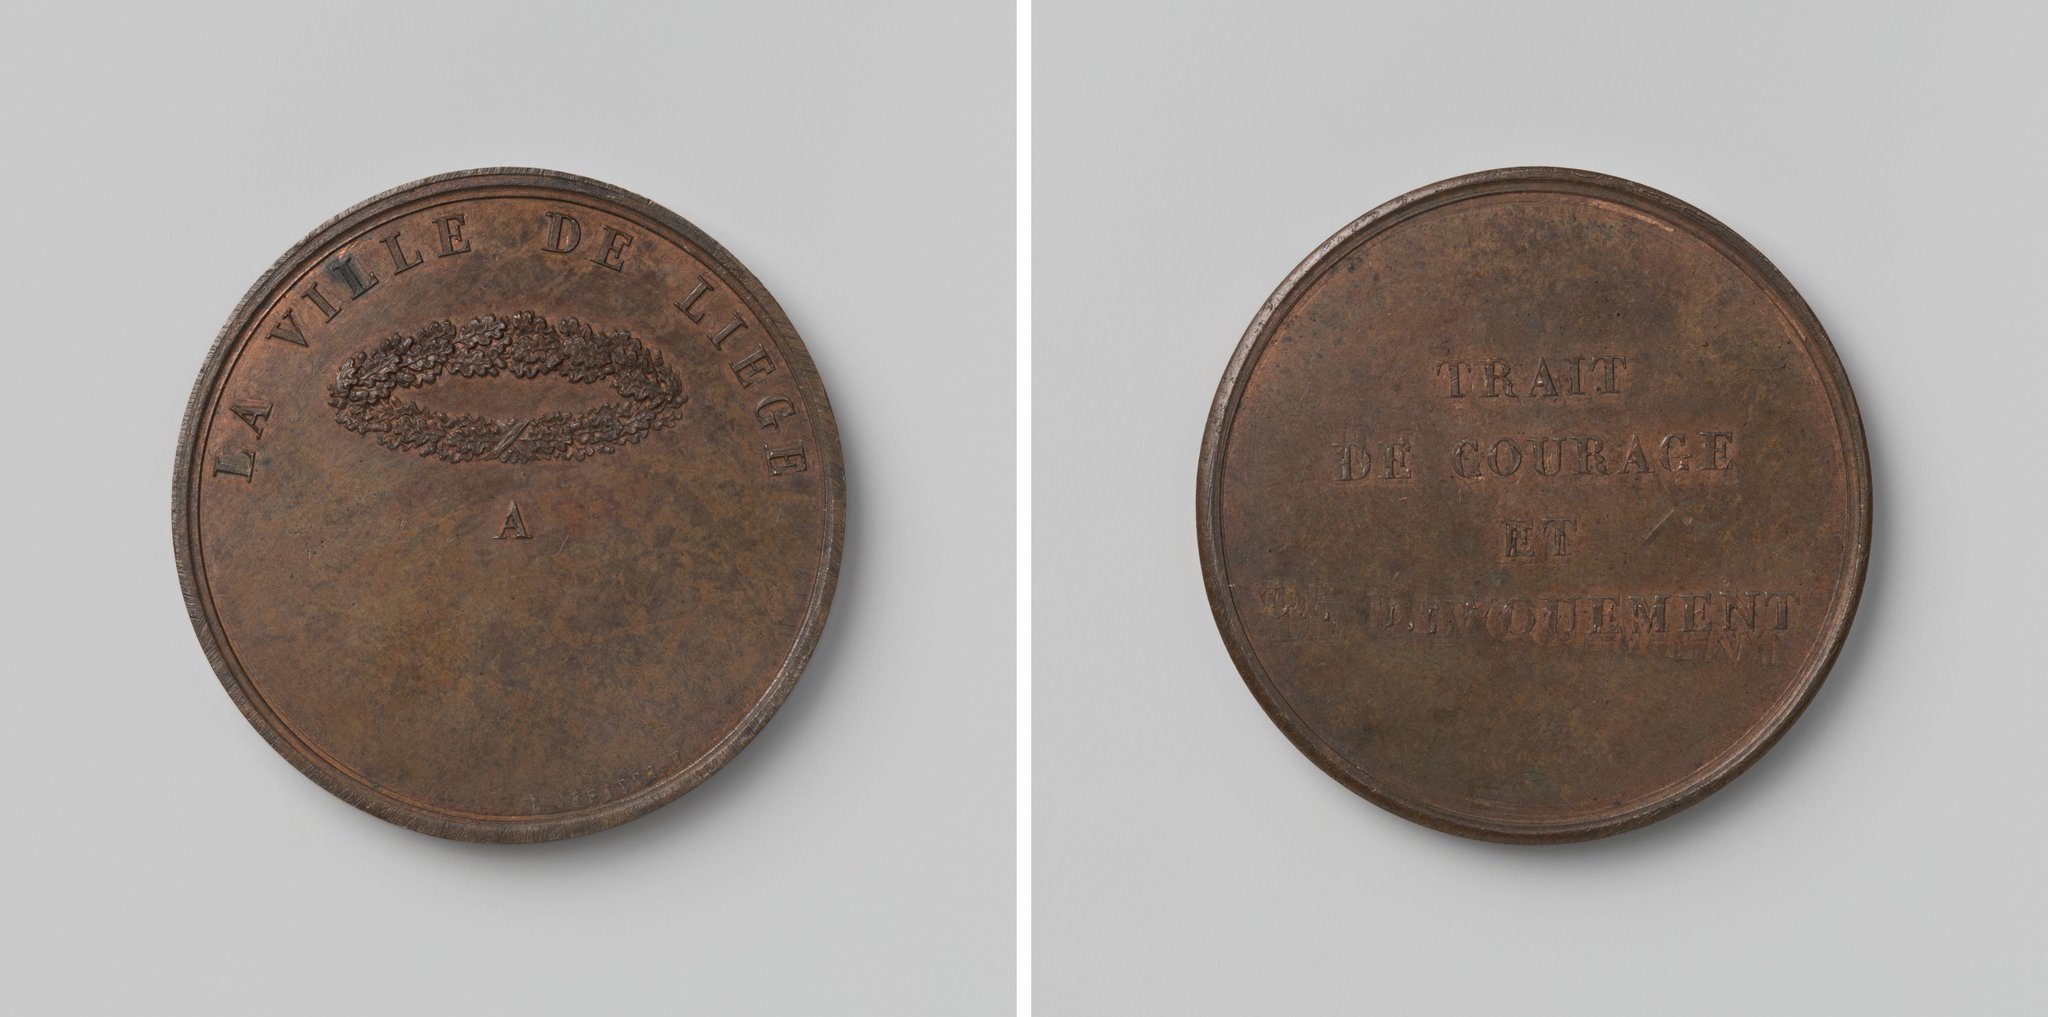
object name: honorary medal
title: Stad Luik, penning uitgereikt voor moed en toewijding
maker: léonard jéhotte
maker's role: print maker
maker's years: 1772-1851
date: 1828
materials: bronze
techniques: striking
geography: liège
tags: liège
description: Bronzen penning. Voorzijde: blanco veld onder eikekrans binnen omschrift. Keerzijde: opschrift